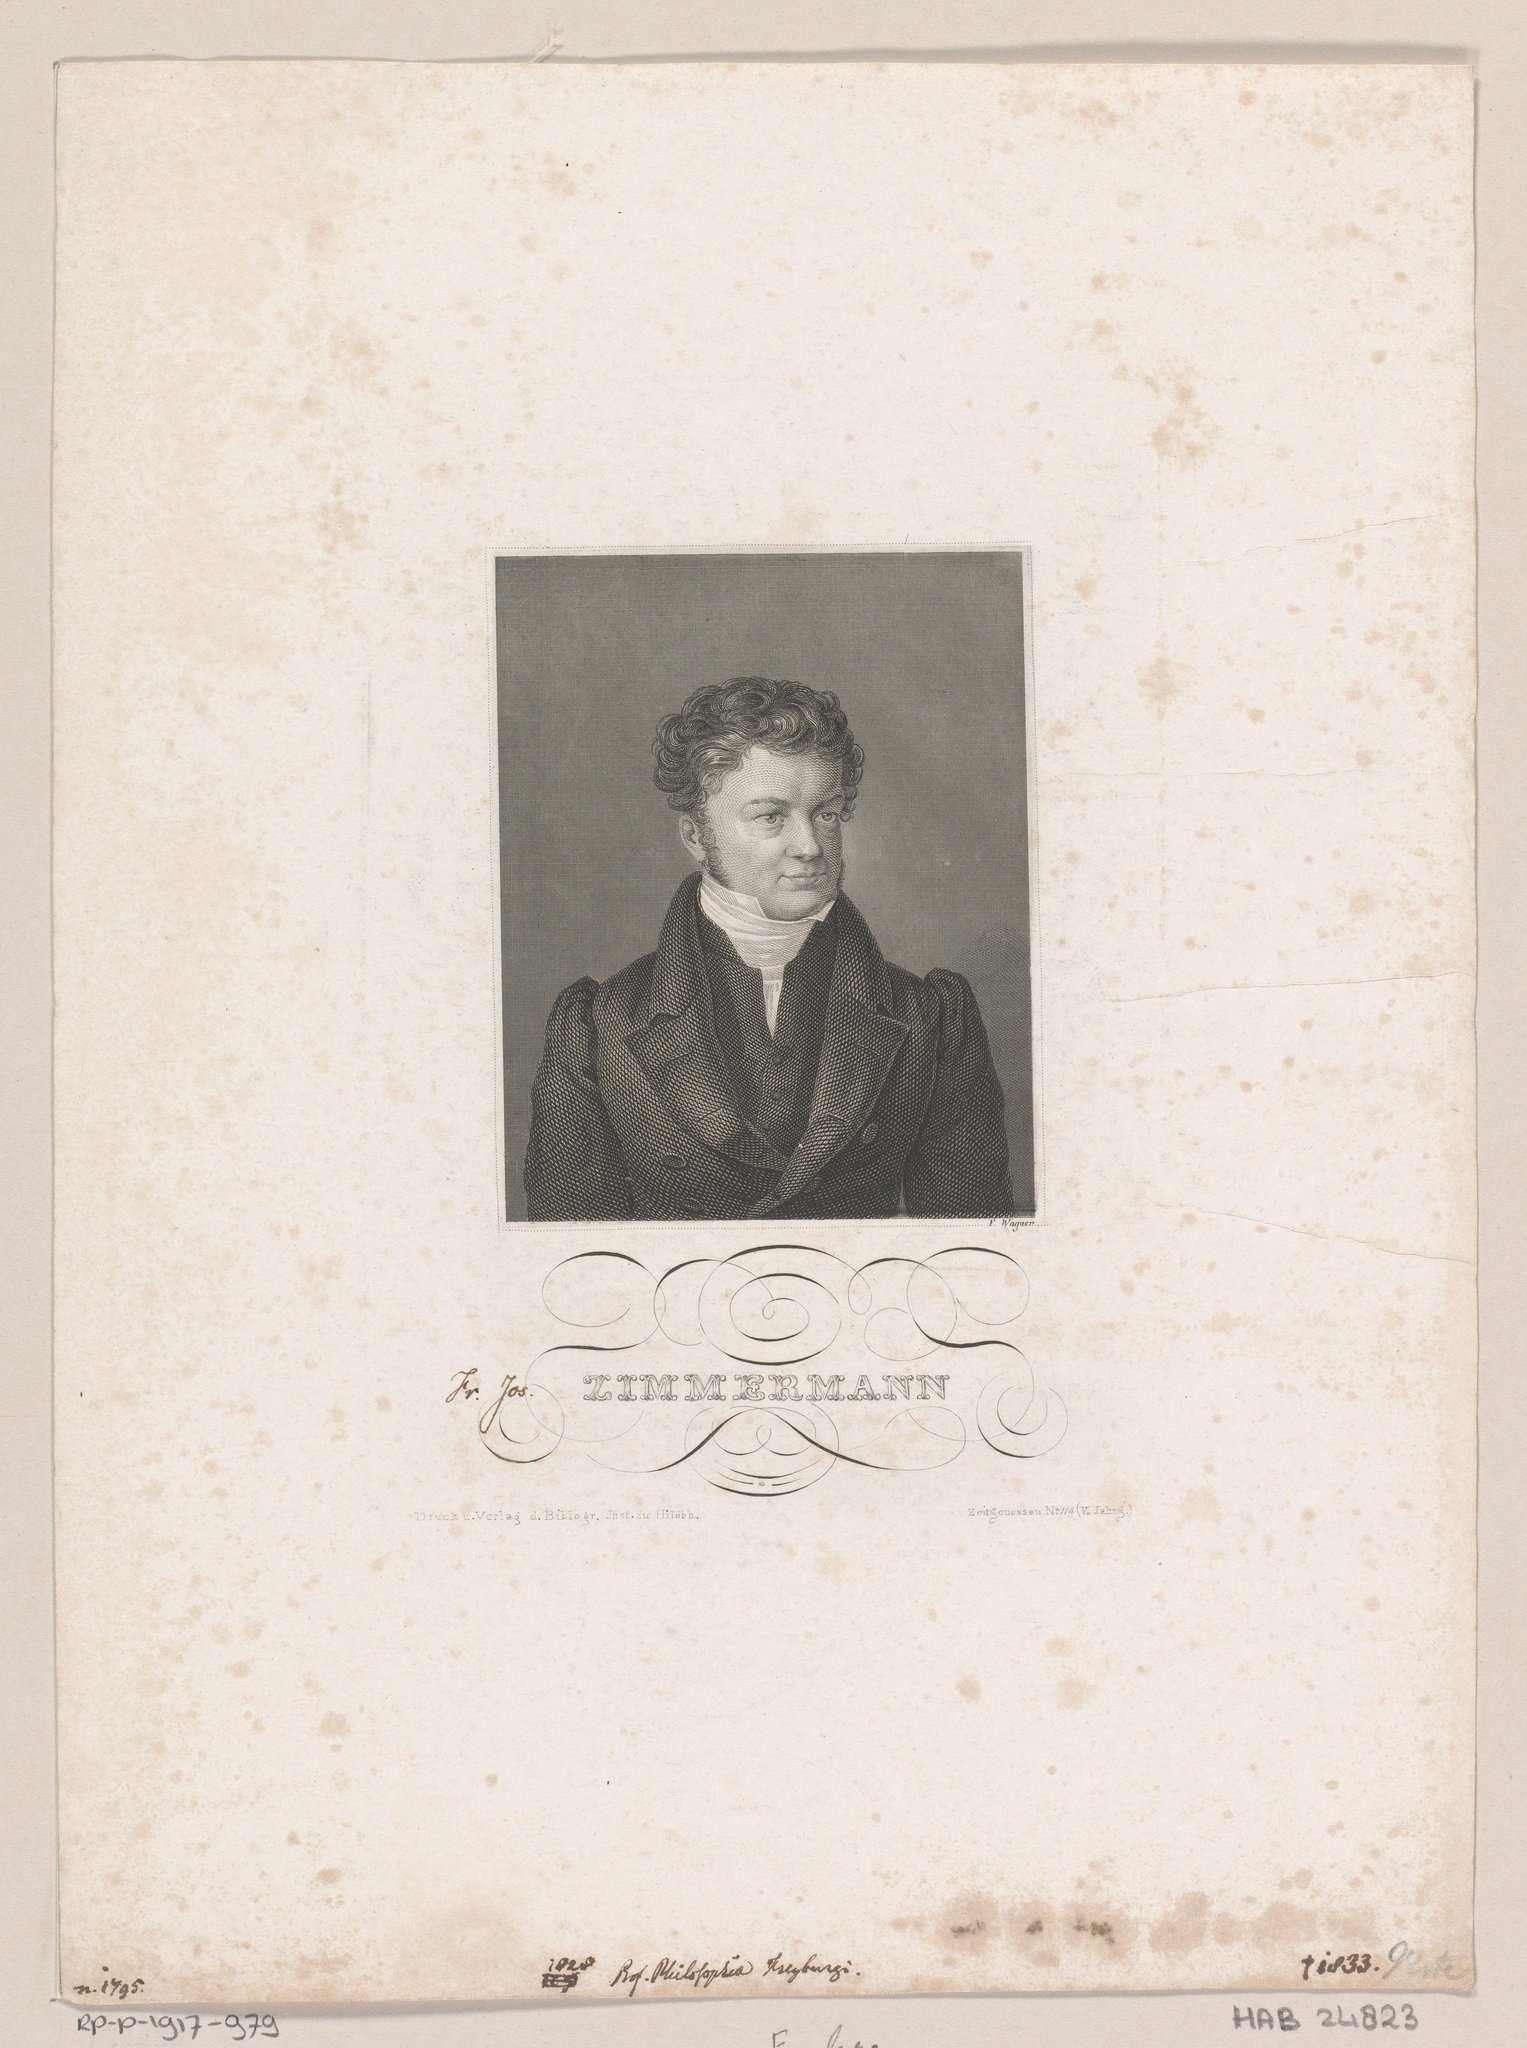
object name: print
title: Tijdgenoten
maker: friedrich wagner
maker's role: painter, print maker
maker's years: 1801-1850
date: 1829-1840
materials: paper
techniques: engraving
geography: hildburghausen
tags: theologian, historical persons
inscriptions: collector's mark: Lugt 2228, inscription: ‘Fr. Jos. / n. 1795 1828 Prof Philosphie [...] = 1833’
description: Afkomstig uit de portretserie 'Zeitgenossen', uitgegeven tussen 1829 en circa 1840. Mogelijk in latere staten nog gebruikt in de series Conversations-Lexicon en Walhalla.